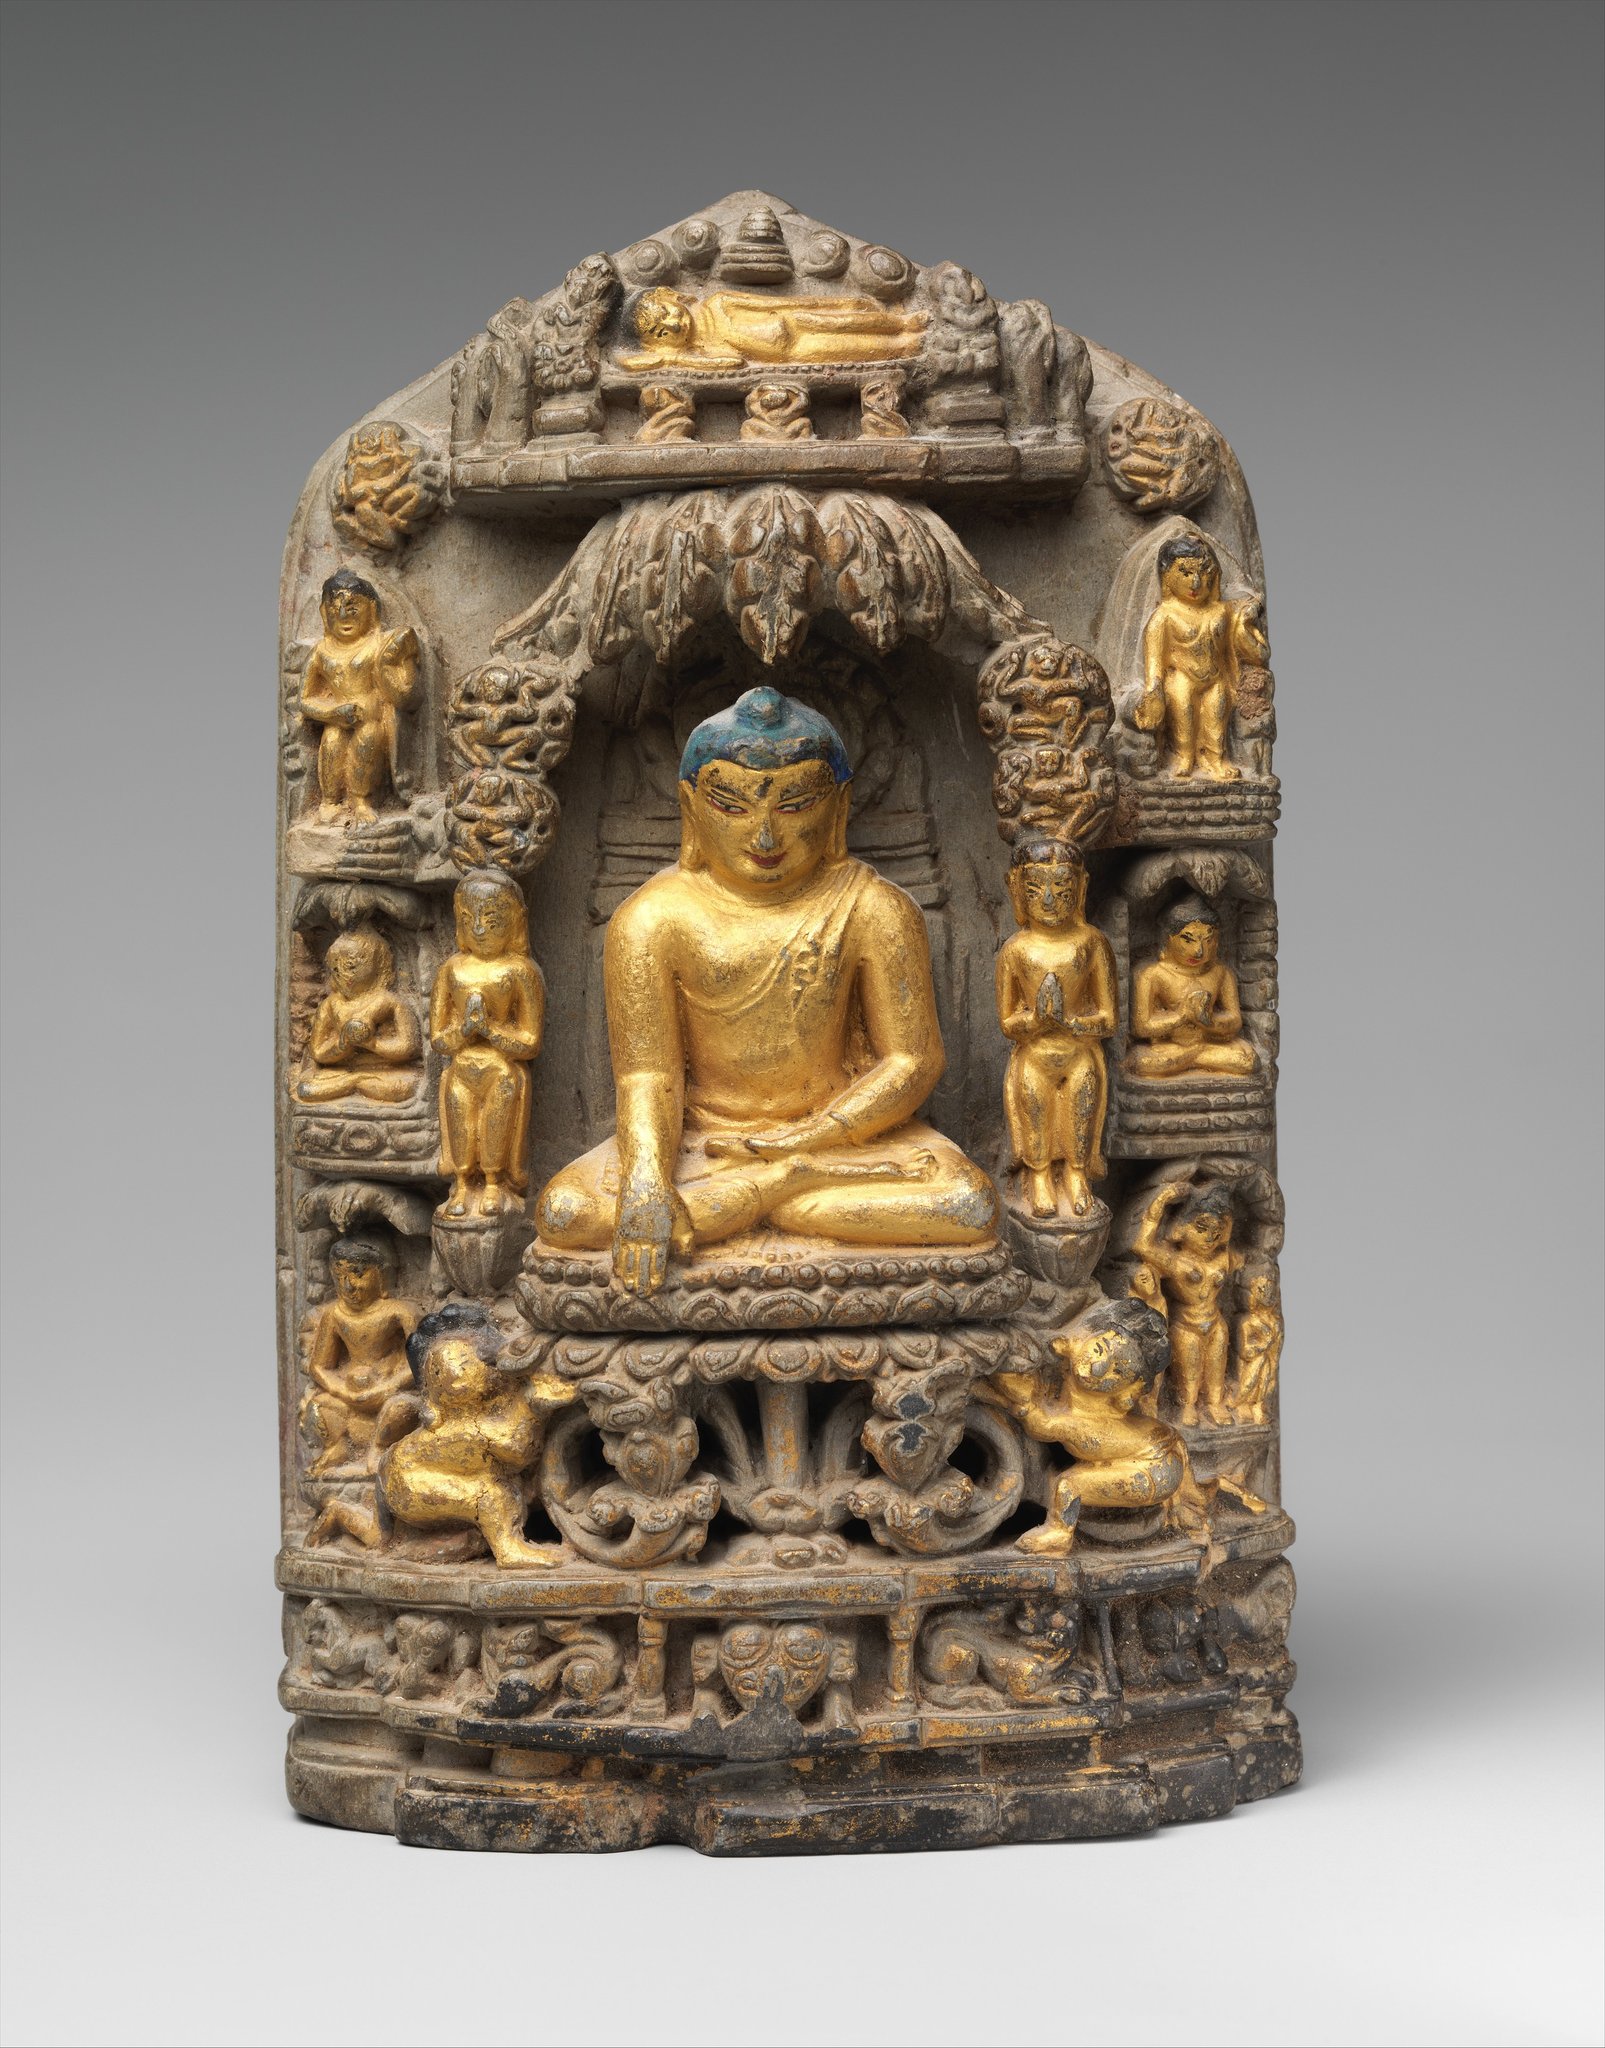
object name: stele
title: Stele with Scenes from the Life of the Buddha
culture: burmese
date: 1001-1200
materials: stone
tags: buddhism,buddha